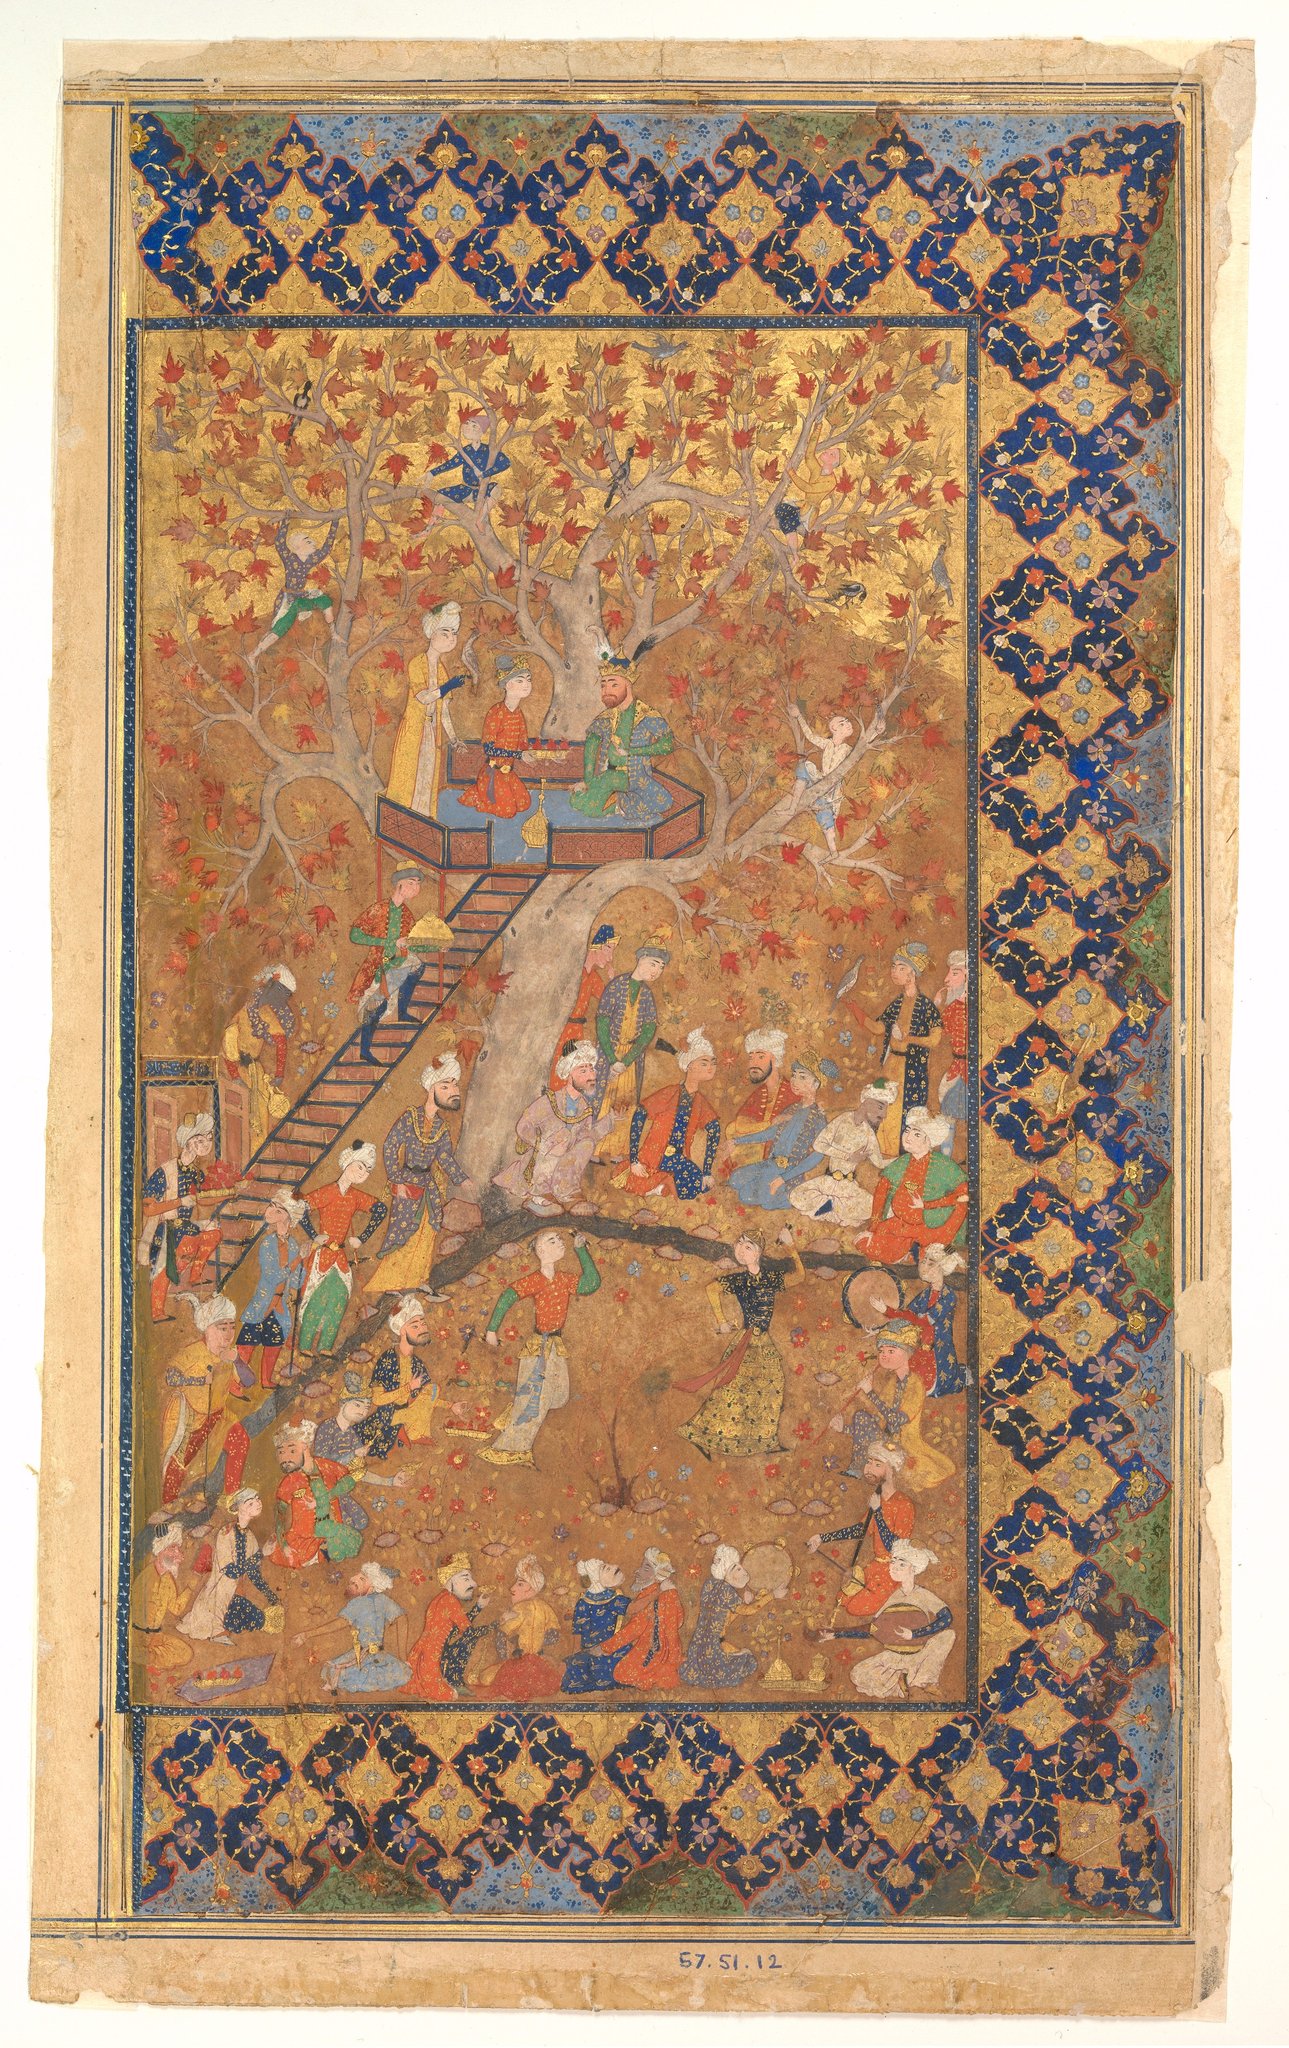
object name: folio from an illustrated manuscript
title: "Entertainment in a Garden", Folio from a Khamsa of Amir Khusrau Dihlavi, Matla' al-Anvar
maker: amir khusrau dihlavi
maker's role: author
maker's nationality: indian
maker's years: 1228-1350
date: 1551-1600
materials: gold, paper, watercolor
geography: iran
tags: men,music,trees,musicians,ladders